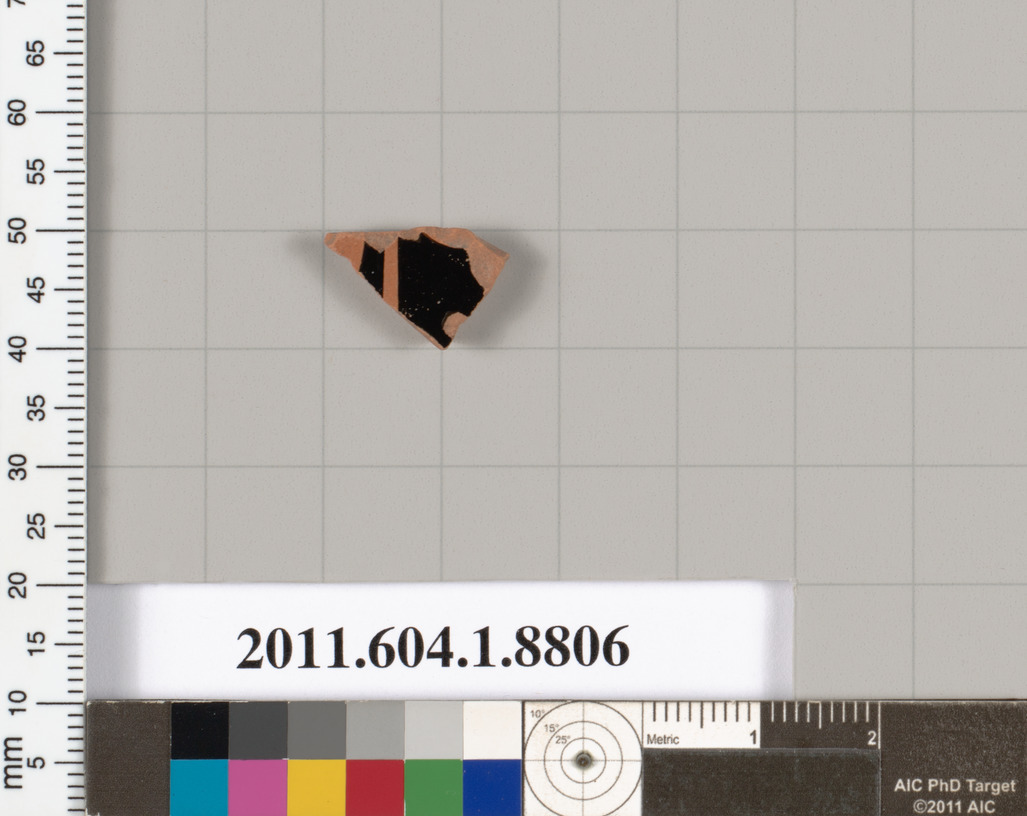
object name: kylix fragment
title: Terracotta fragment of a kylix (drinking cup)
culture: greek, attic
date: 490-480 BCE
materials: terracotta